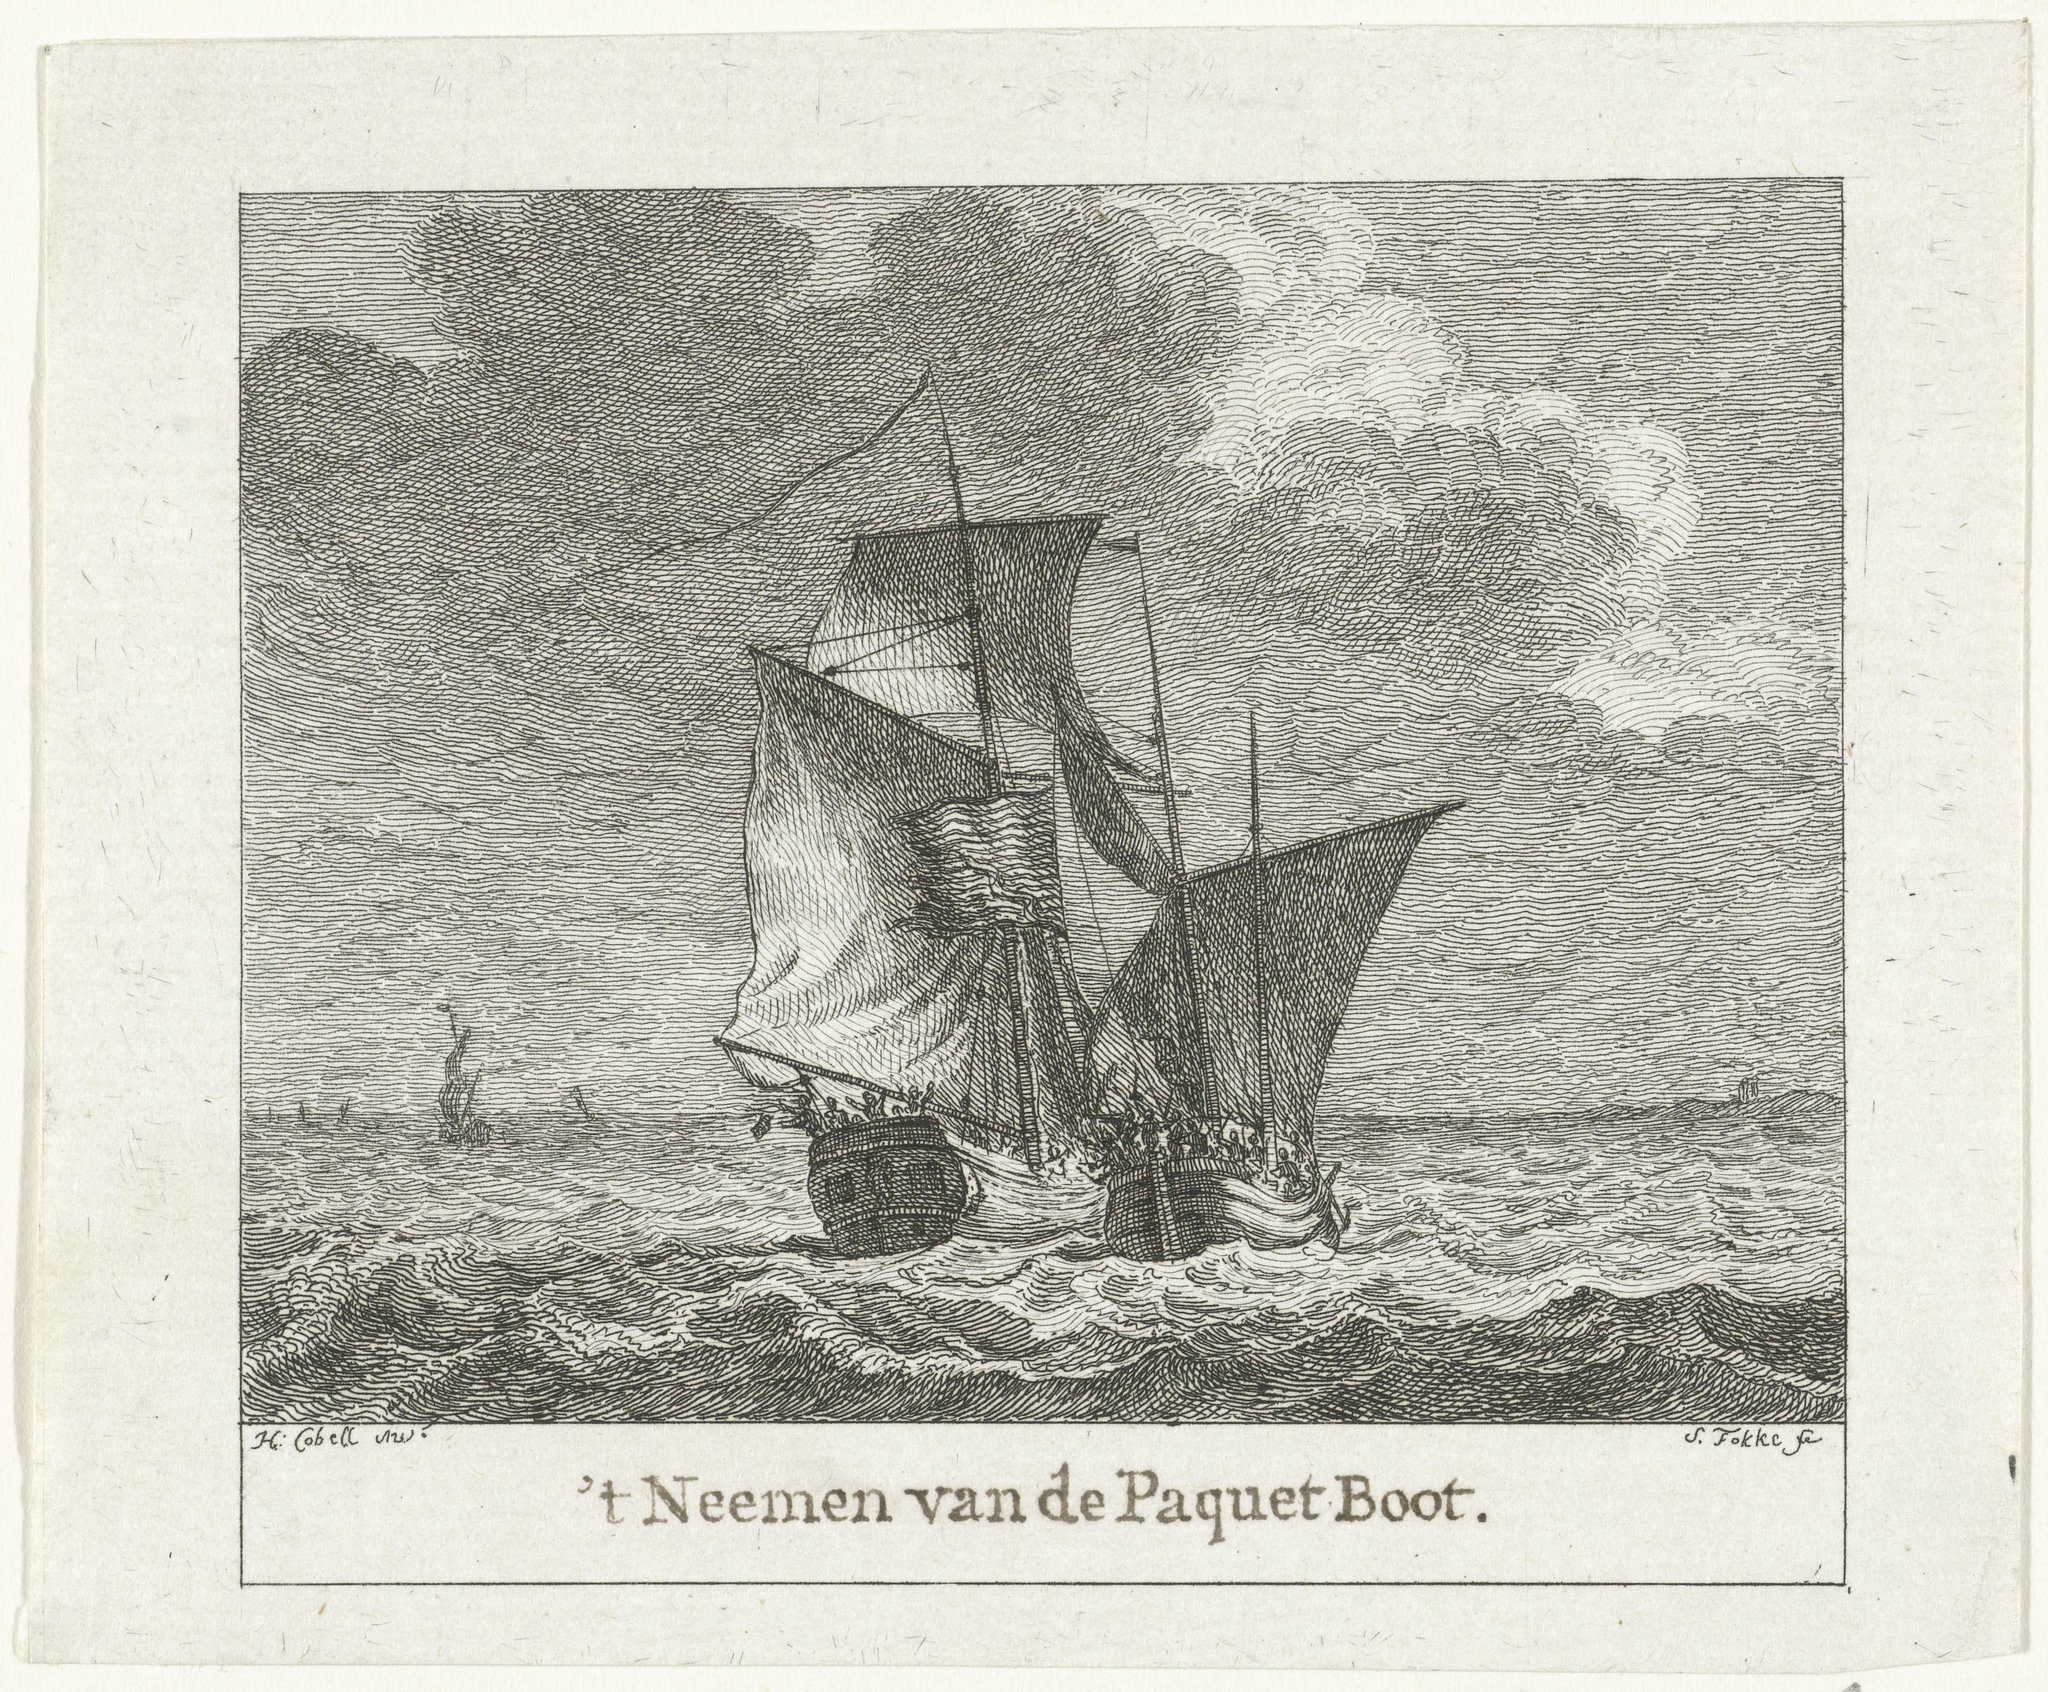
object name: print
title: 't Neemen van de Paquet Boot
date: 1783-1784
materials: paper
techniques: engraving, etching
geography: northern netherlands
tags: piracy, english channel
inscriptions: inscription: ‘'t Neemen van de Paquet Boot’, collector's mark: Lugt 2228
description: Gebruikt als illustratie in: Arend Fokke Simonsz. De vaderlandsche historie in themata. Amsterdam: Arend Fokke Simonsz., edities tussen 1783-ca. 1792.